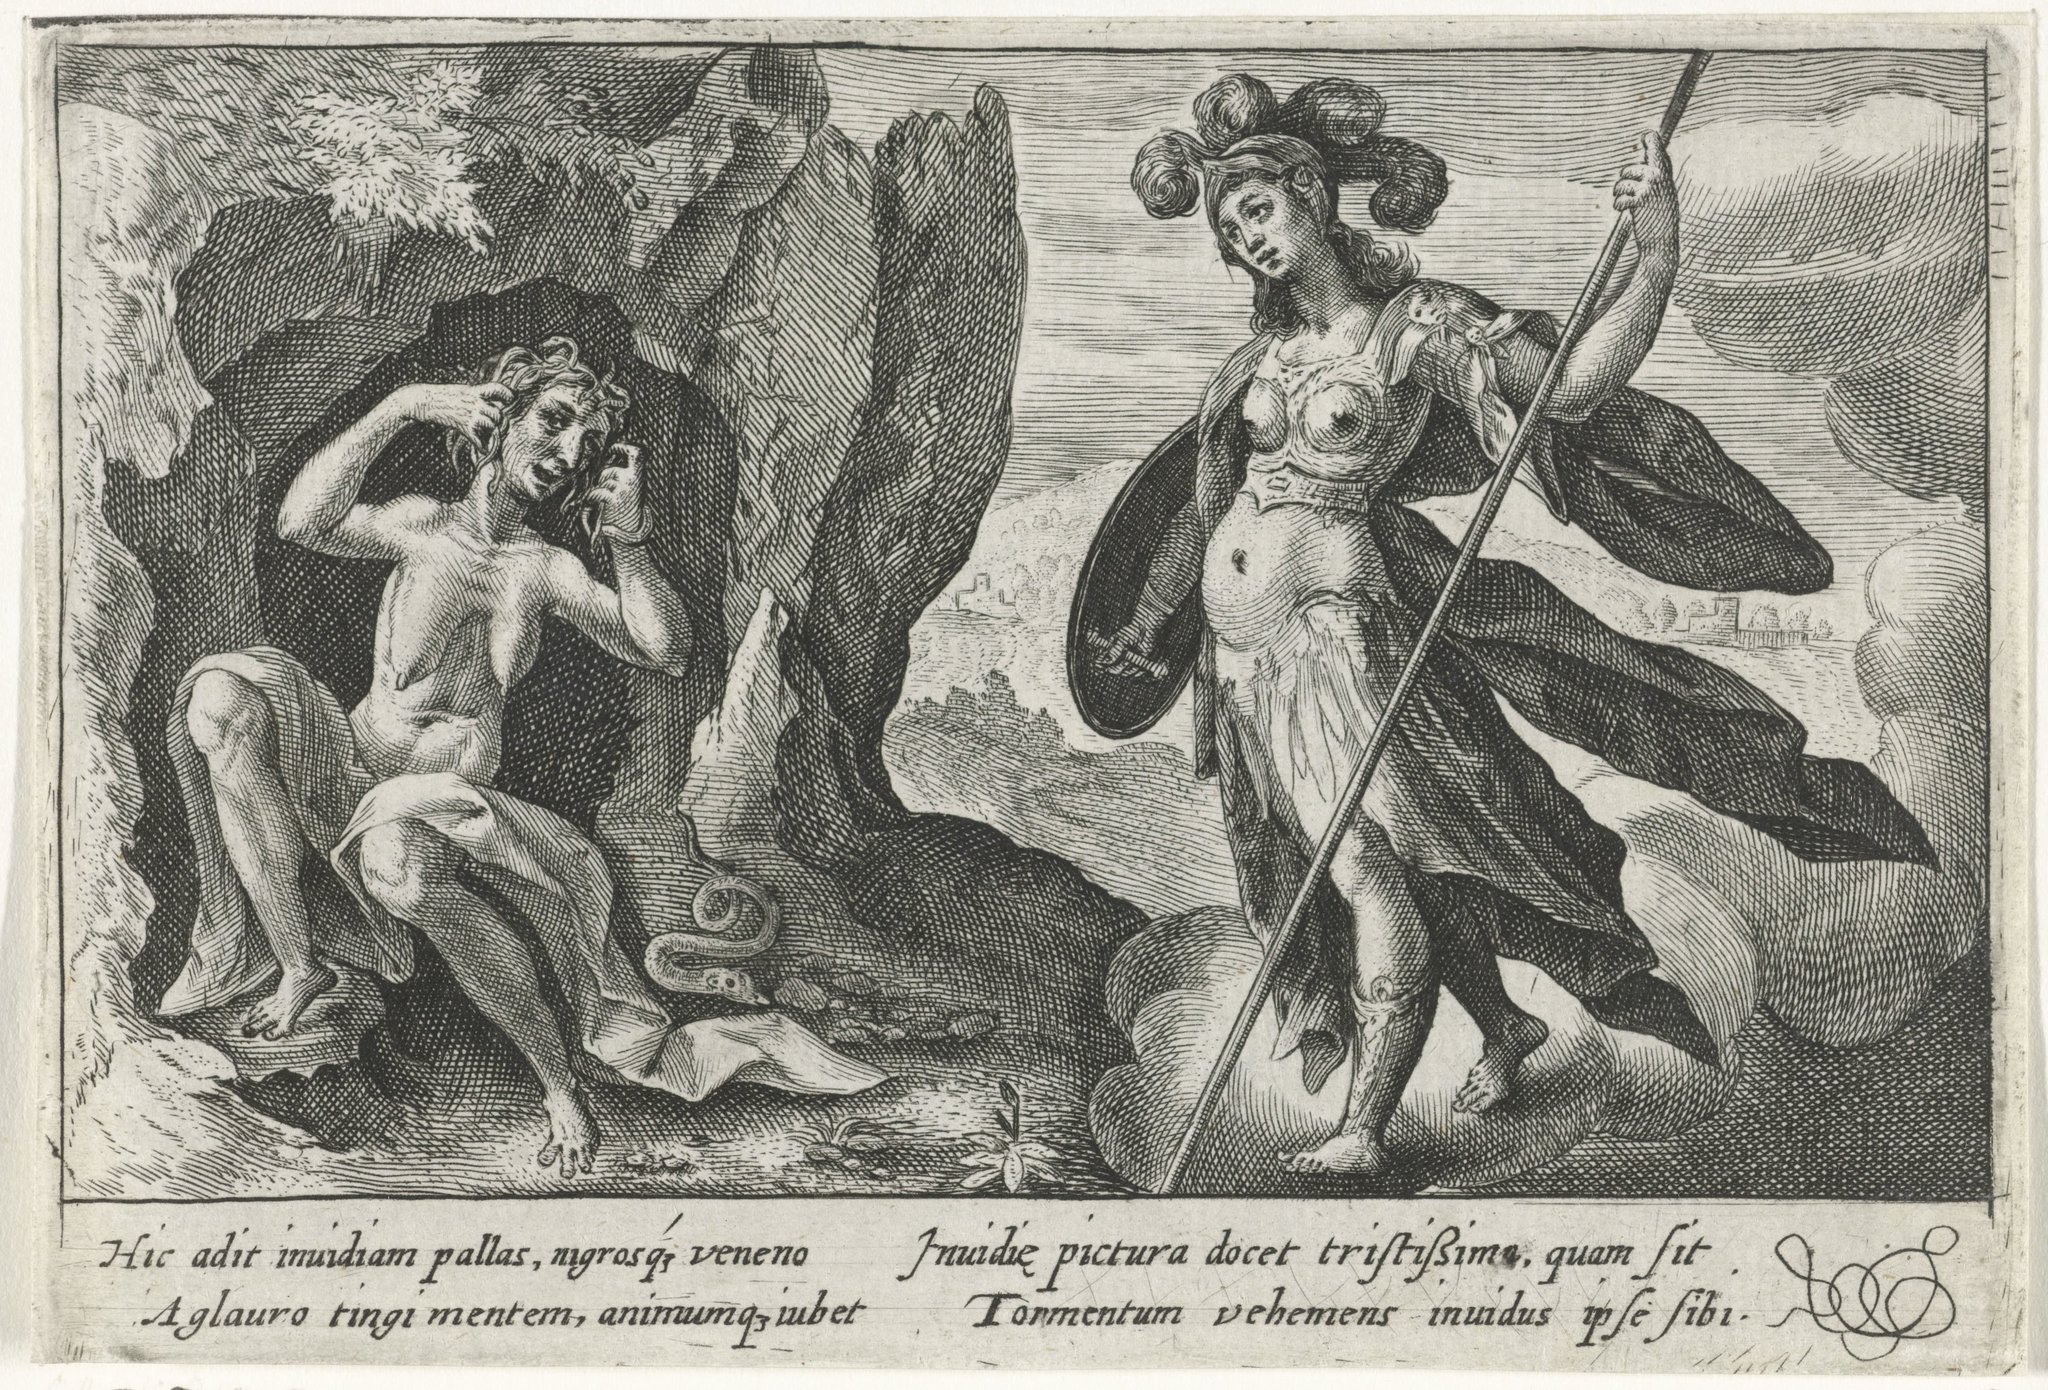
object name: print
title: Metamorfosen van Ovidius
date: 1602-1607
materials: paper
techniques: engraving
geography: cologne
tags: minerva visits the cave of envy (invidia) in order to punish aglauros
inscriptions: collector's mark: Lugt 2228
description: Minerva bezoekt Afgunst (Invidia) in haar grot en draagt haar op om Aglauros jaloers te maken. In de marge een vierregelig onderschrift, in twee kolommen, in het Latijn.